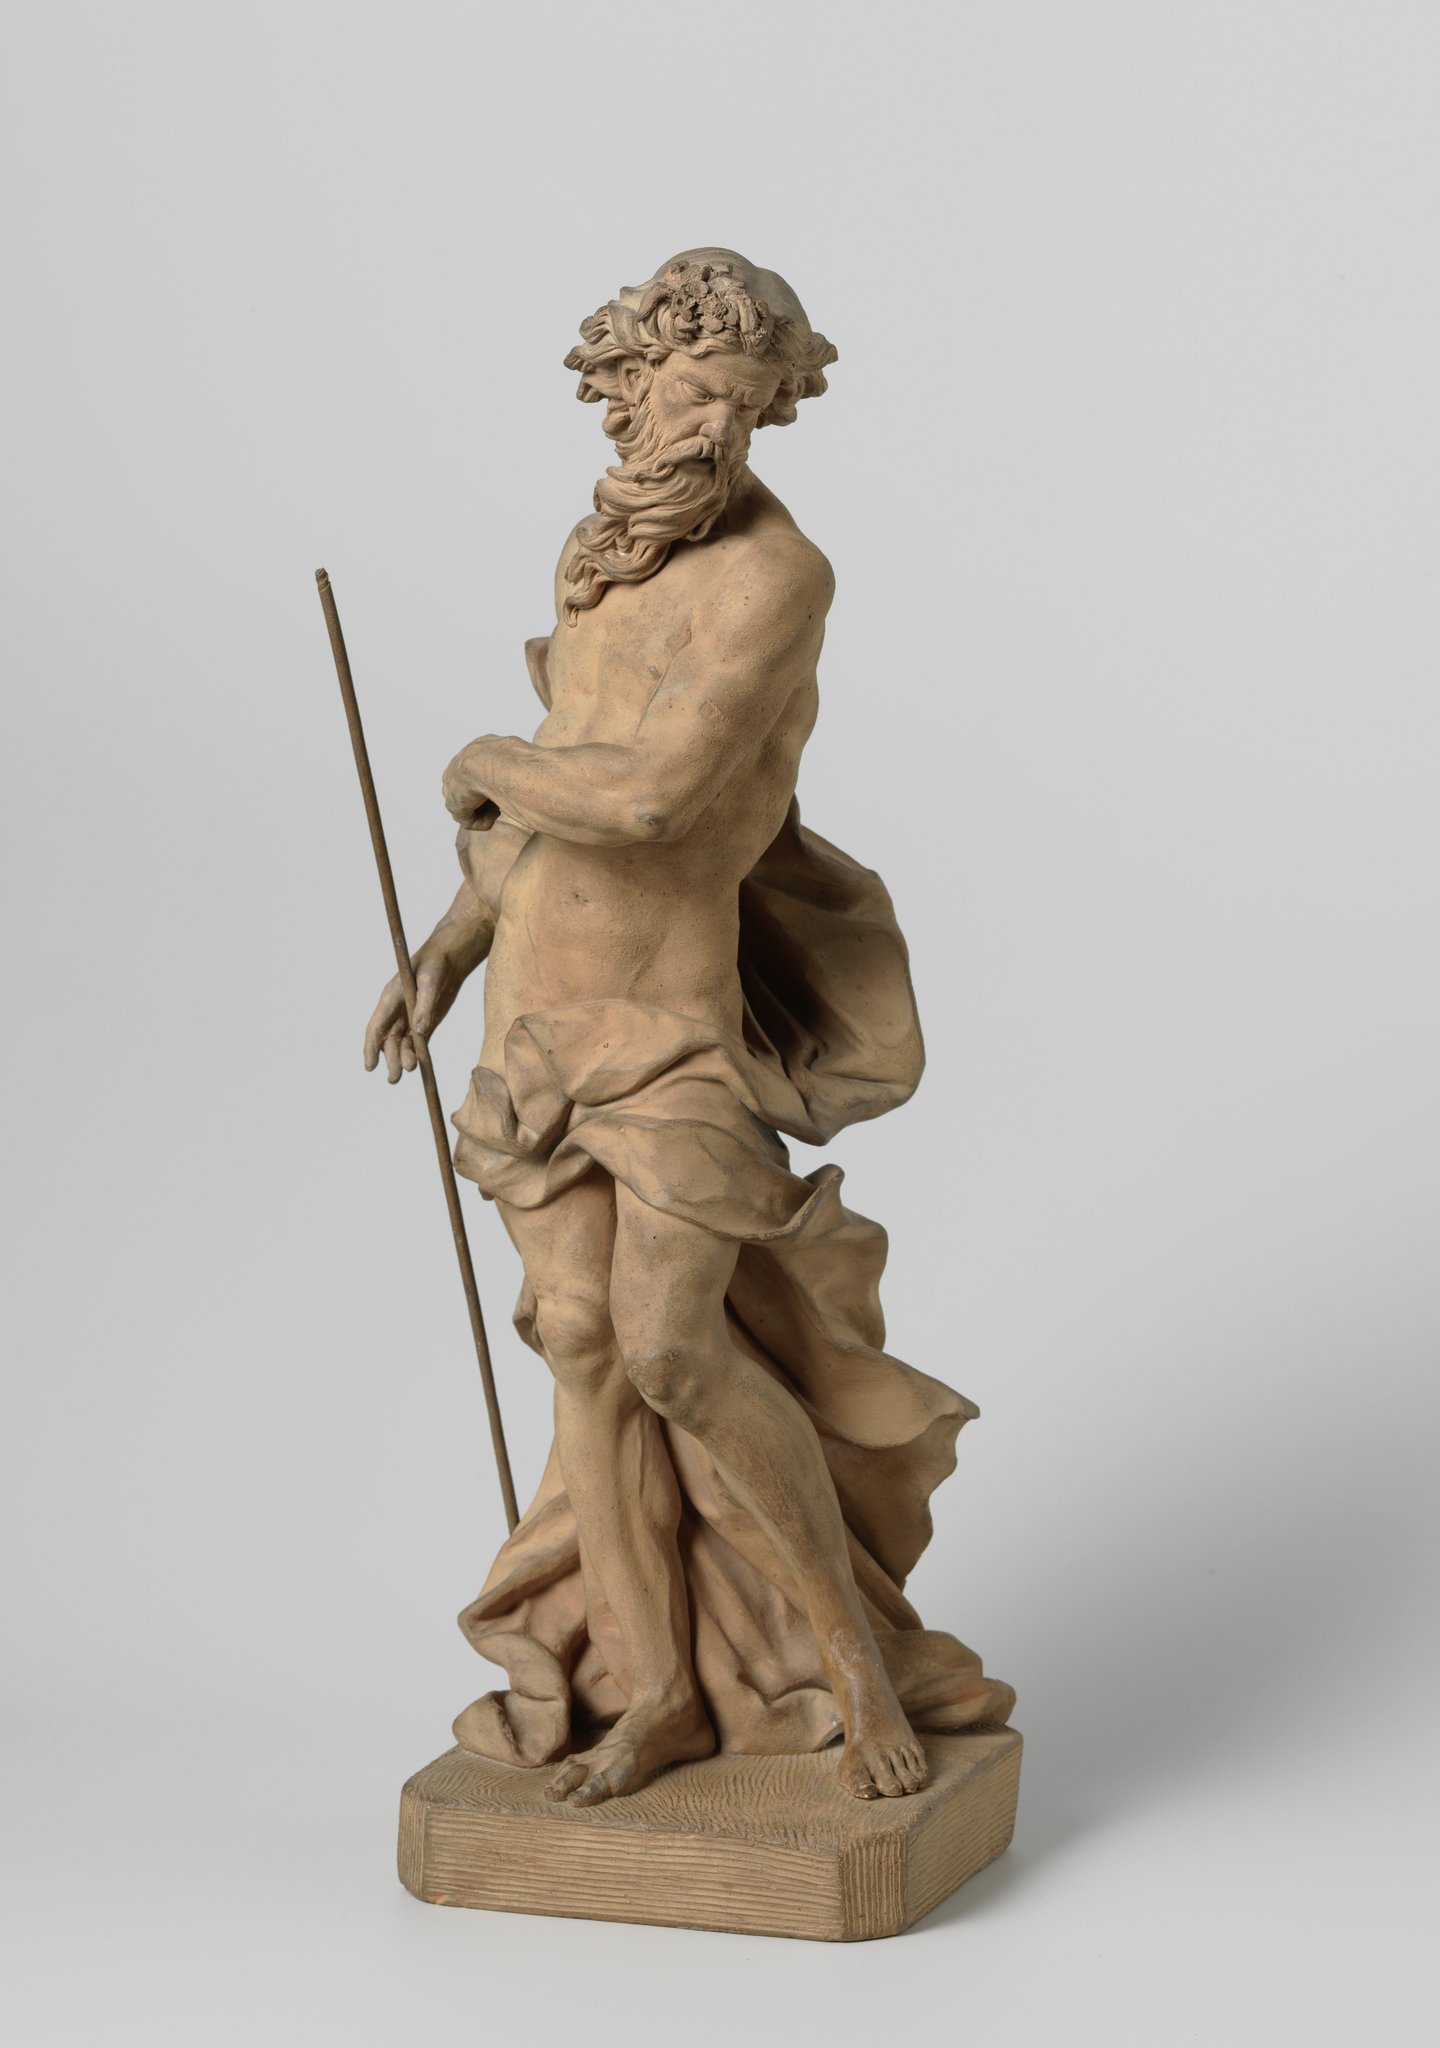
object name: sculpture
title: Neptunus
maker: willem hendrik van der wall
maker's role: sculptor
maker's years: 1716-1790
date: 1757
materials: terracotta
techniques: modeling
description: Willem Hendrik van de Wall (1716 - 1790). Mars and Neptune. Terracotta. Utrecht, 1757.